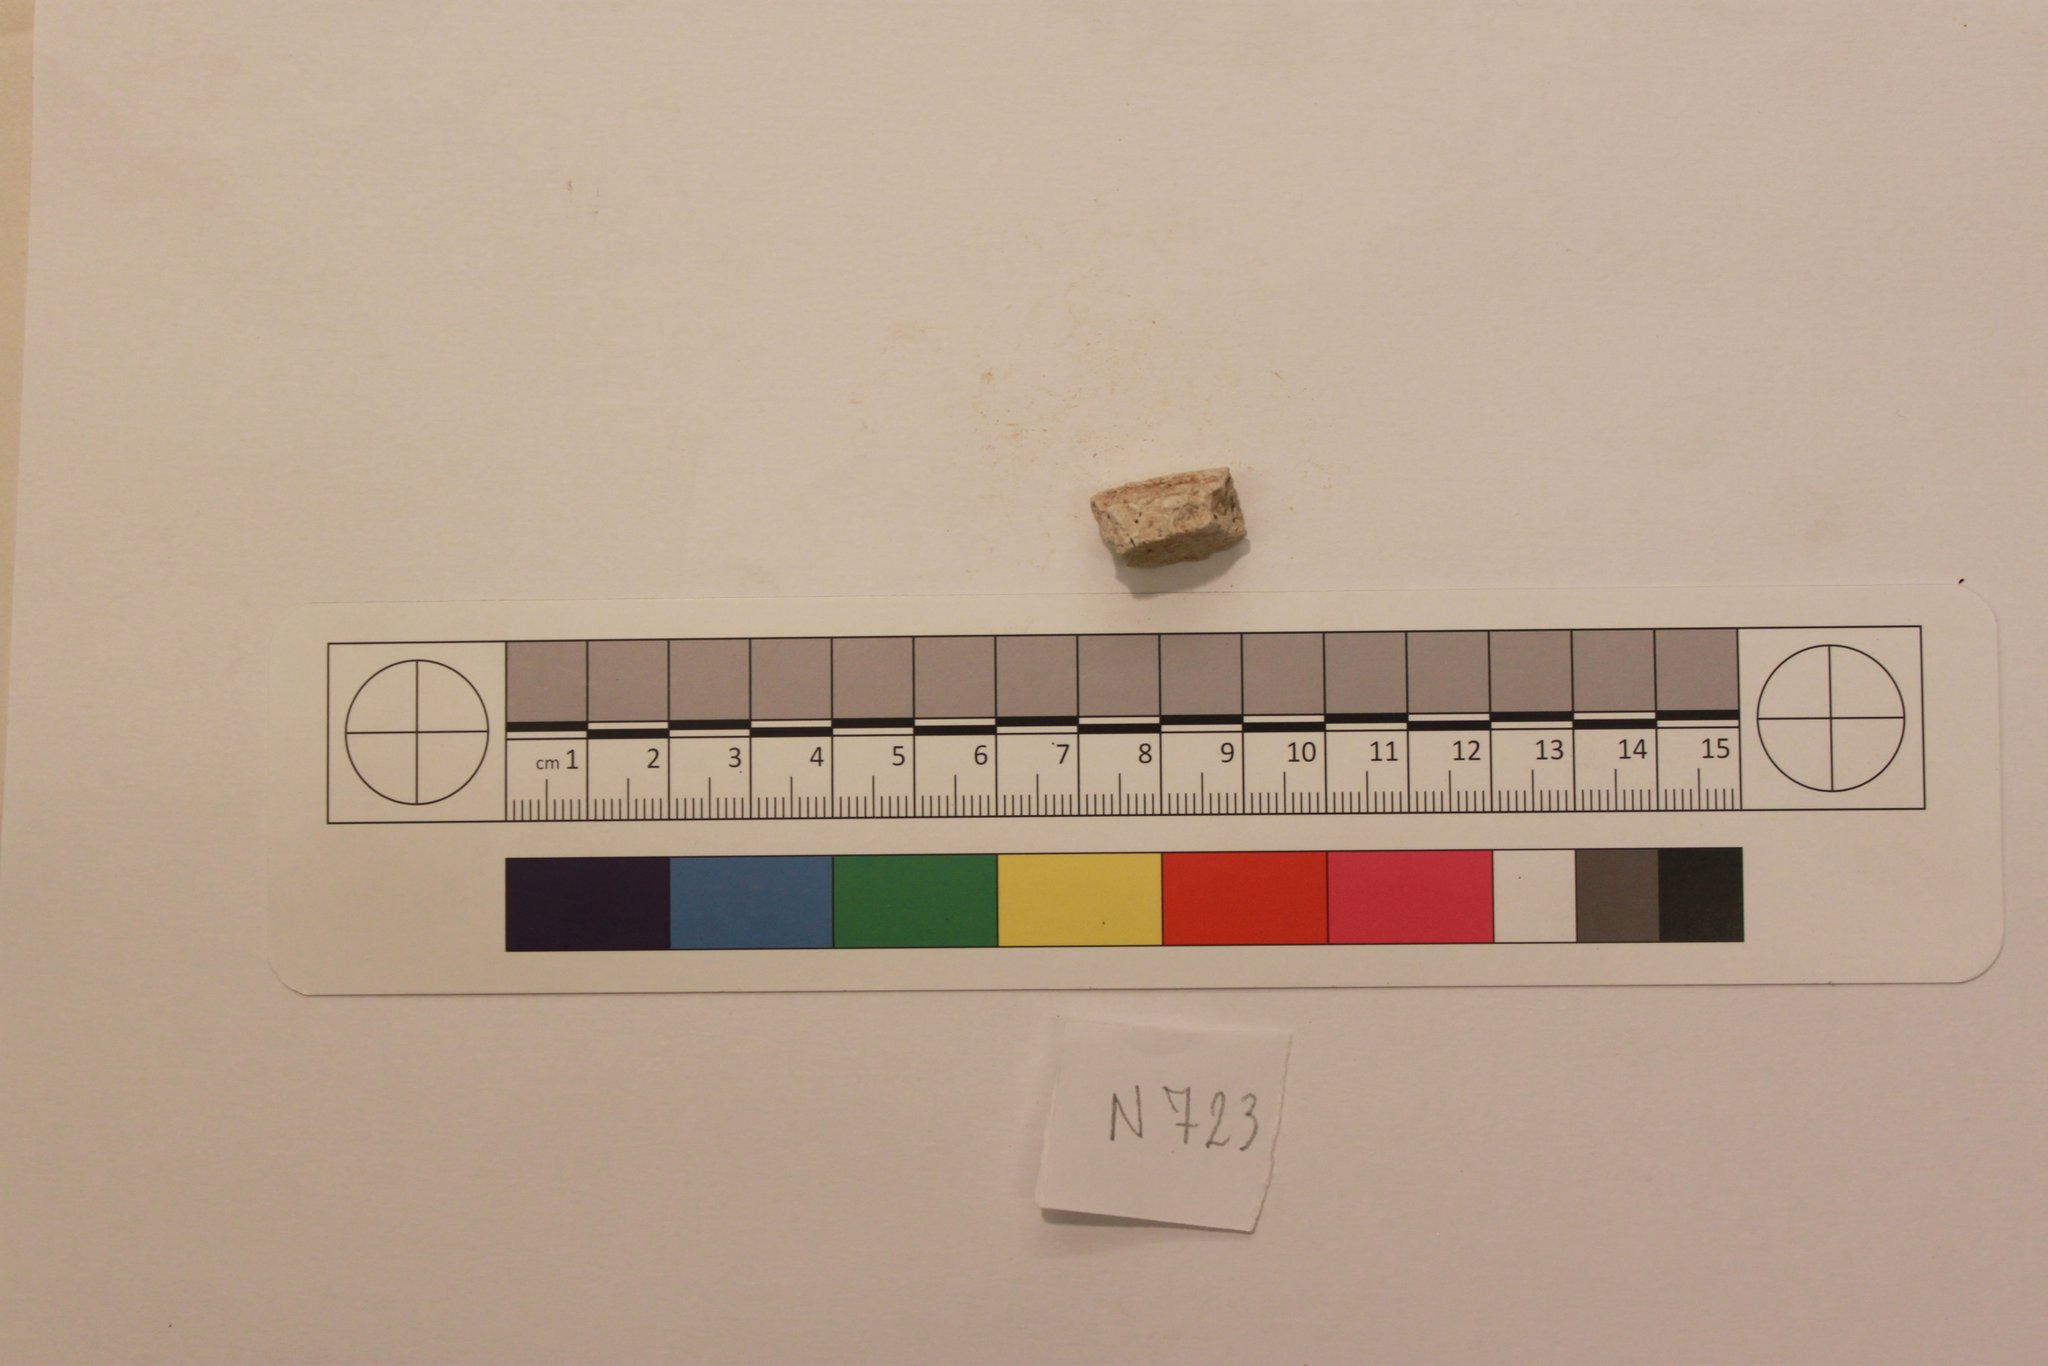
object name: fragment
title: Stucco Fragment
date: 701-1200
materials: plaster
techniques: carving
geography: iran